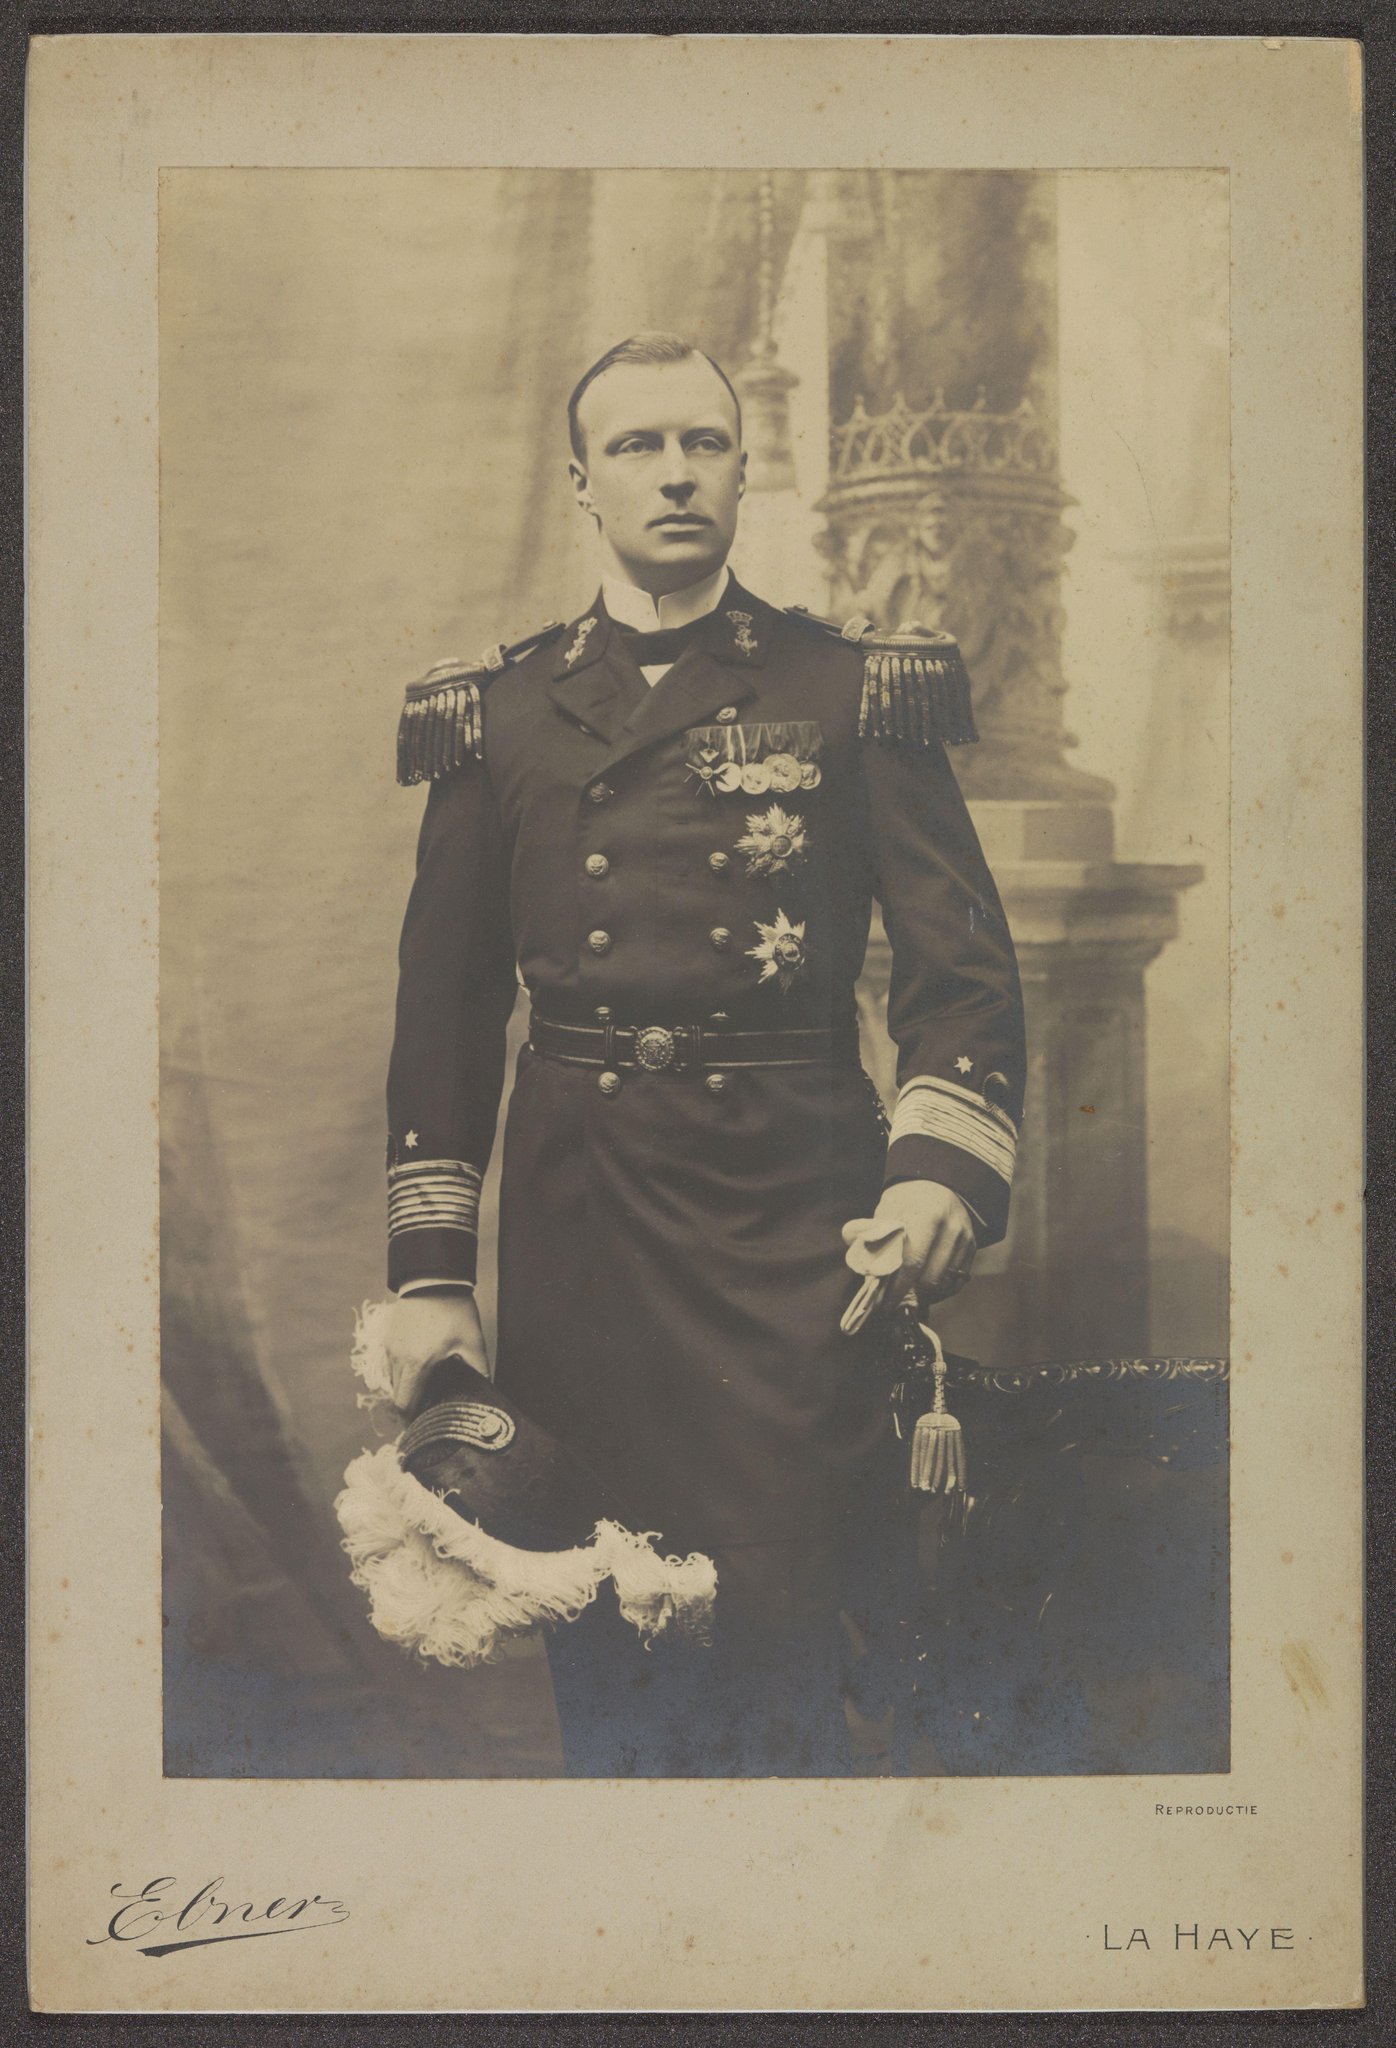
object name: photograph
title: Portret van Prins Hendrik in marine uniform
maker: ferdinand robert ebner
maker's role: fotograaf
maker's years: 1873-1919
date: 1901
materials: cardboard, photographic support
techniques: gelatin silver print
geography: the hague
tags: the hague, hendrik (prins der nederlanden (1876-1934))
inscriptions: inscription: ‘Prins Hendrik 1901’, annotation: ‘reproductie. Ebner La Haye’